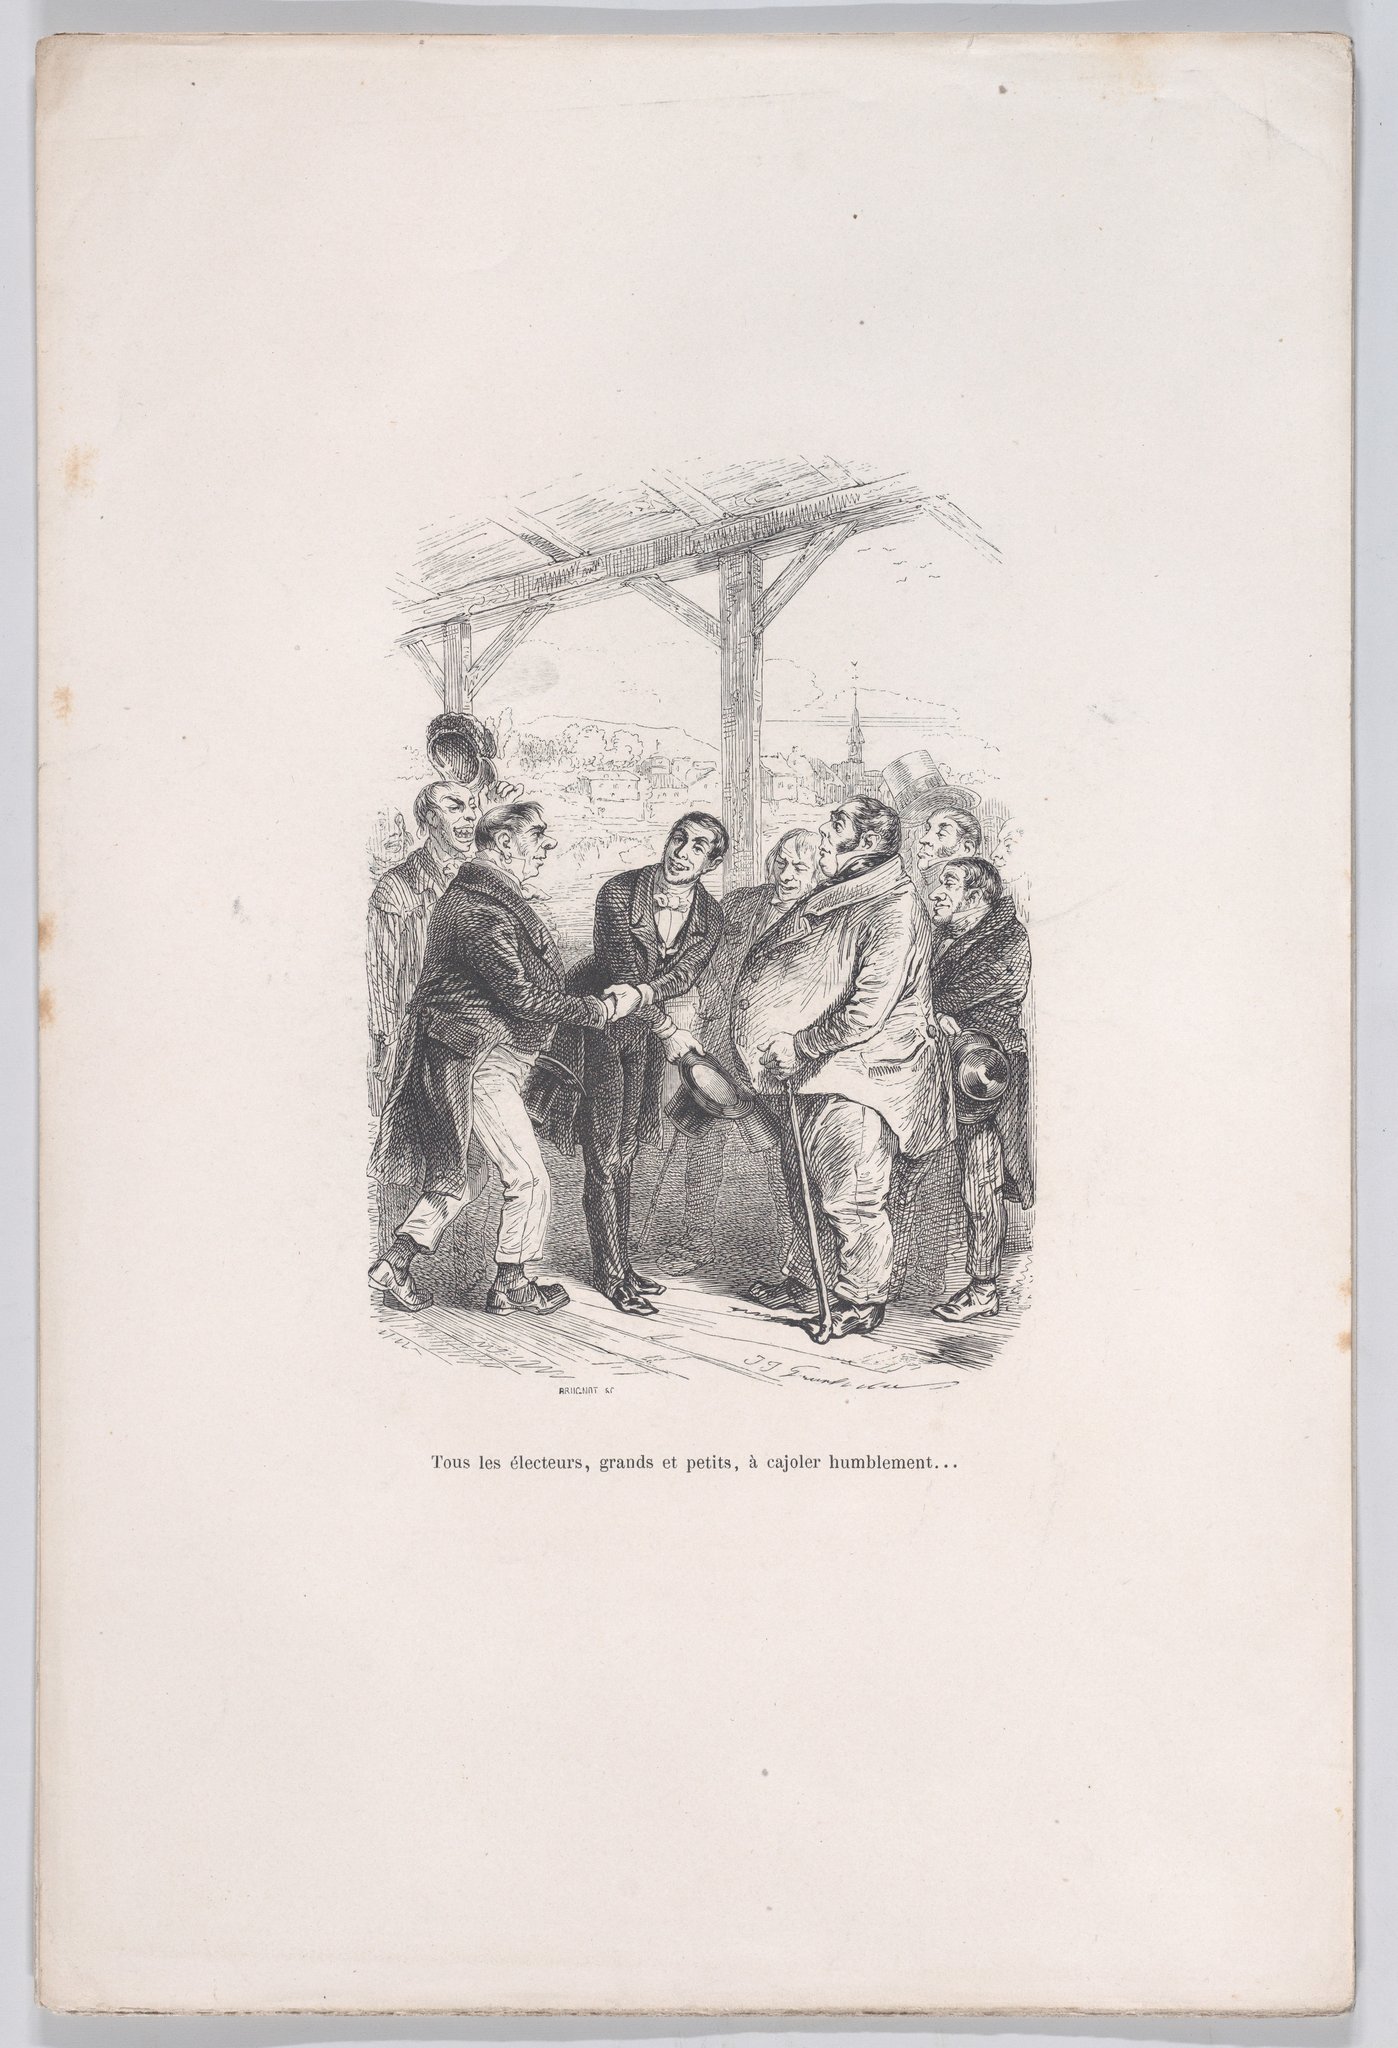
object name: print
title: All voters, big and small, gather to humbly coax each other..., from "Little Miseries of Human Life"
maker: j. j. grandville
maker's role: illustrator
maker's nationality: french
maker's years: 1803-1847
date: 1843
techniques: engraving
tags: men